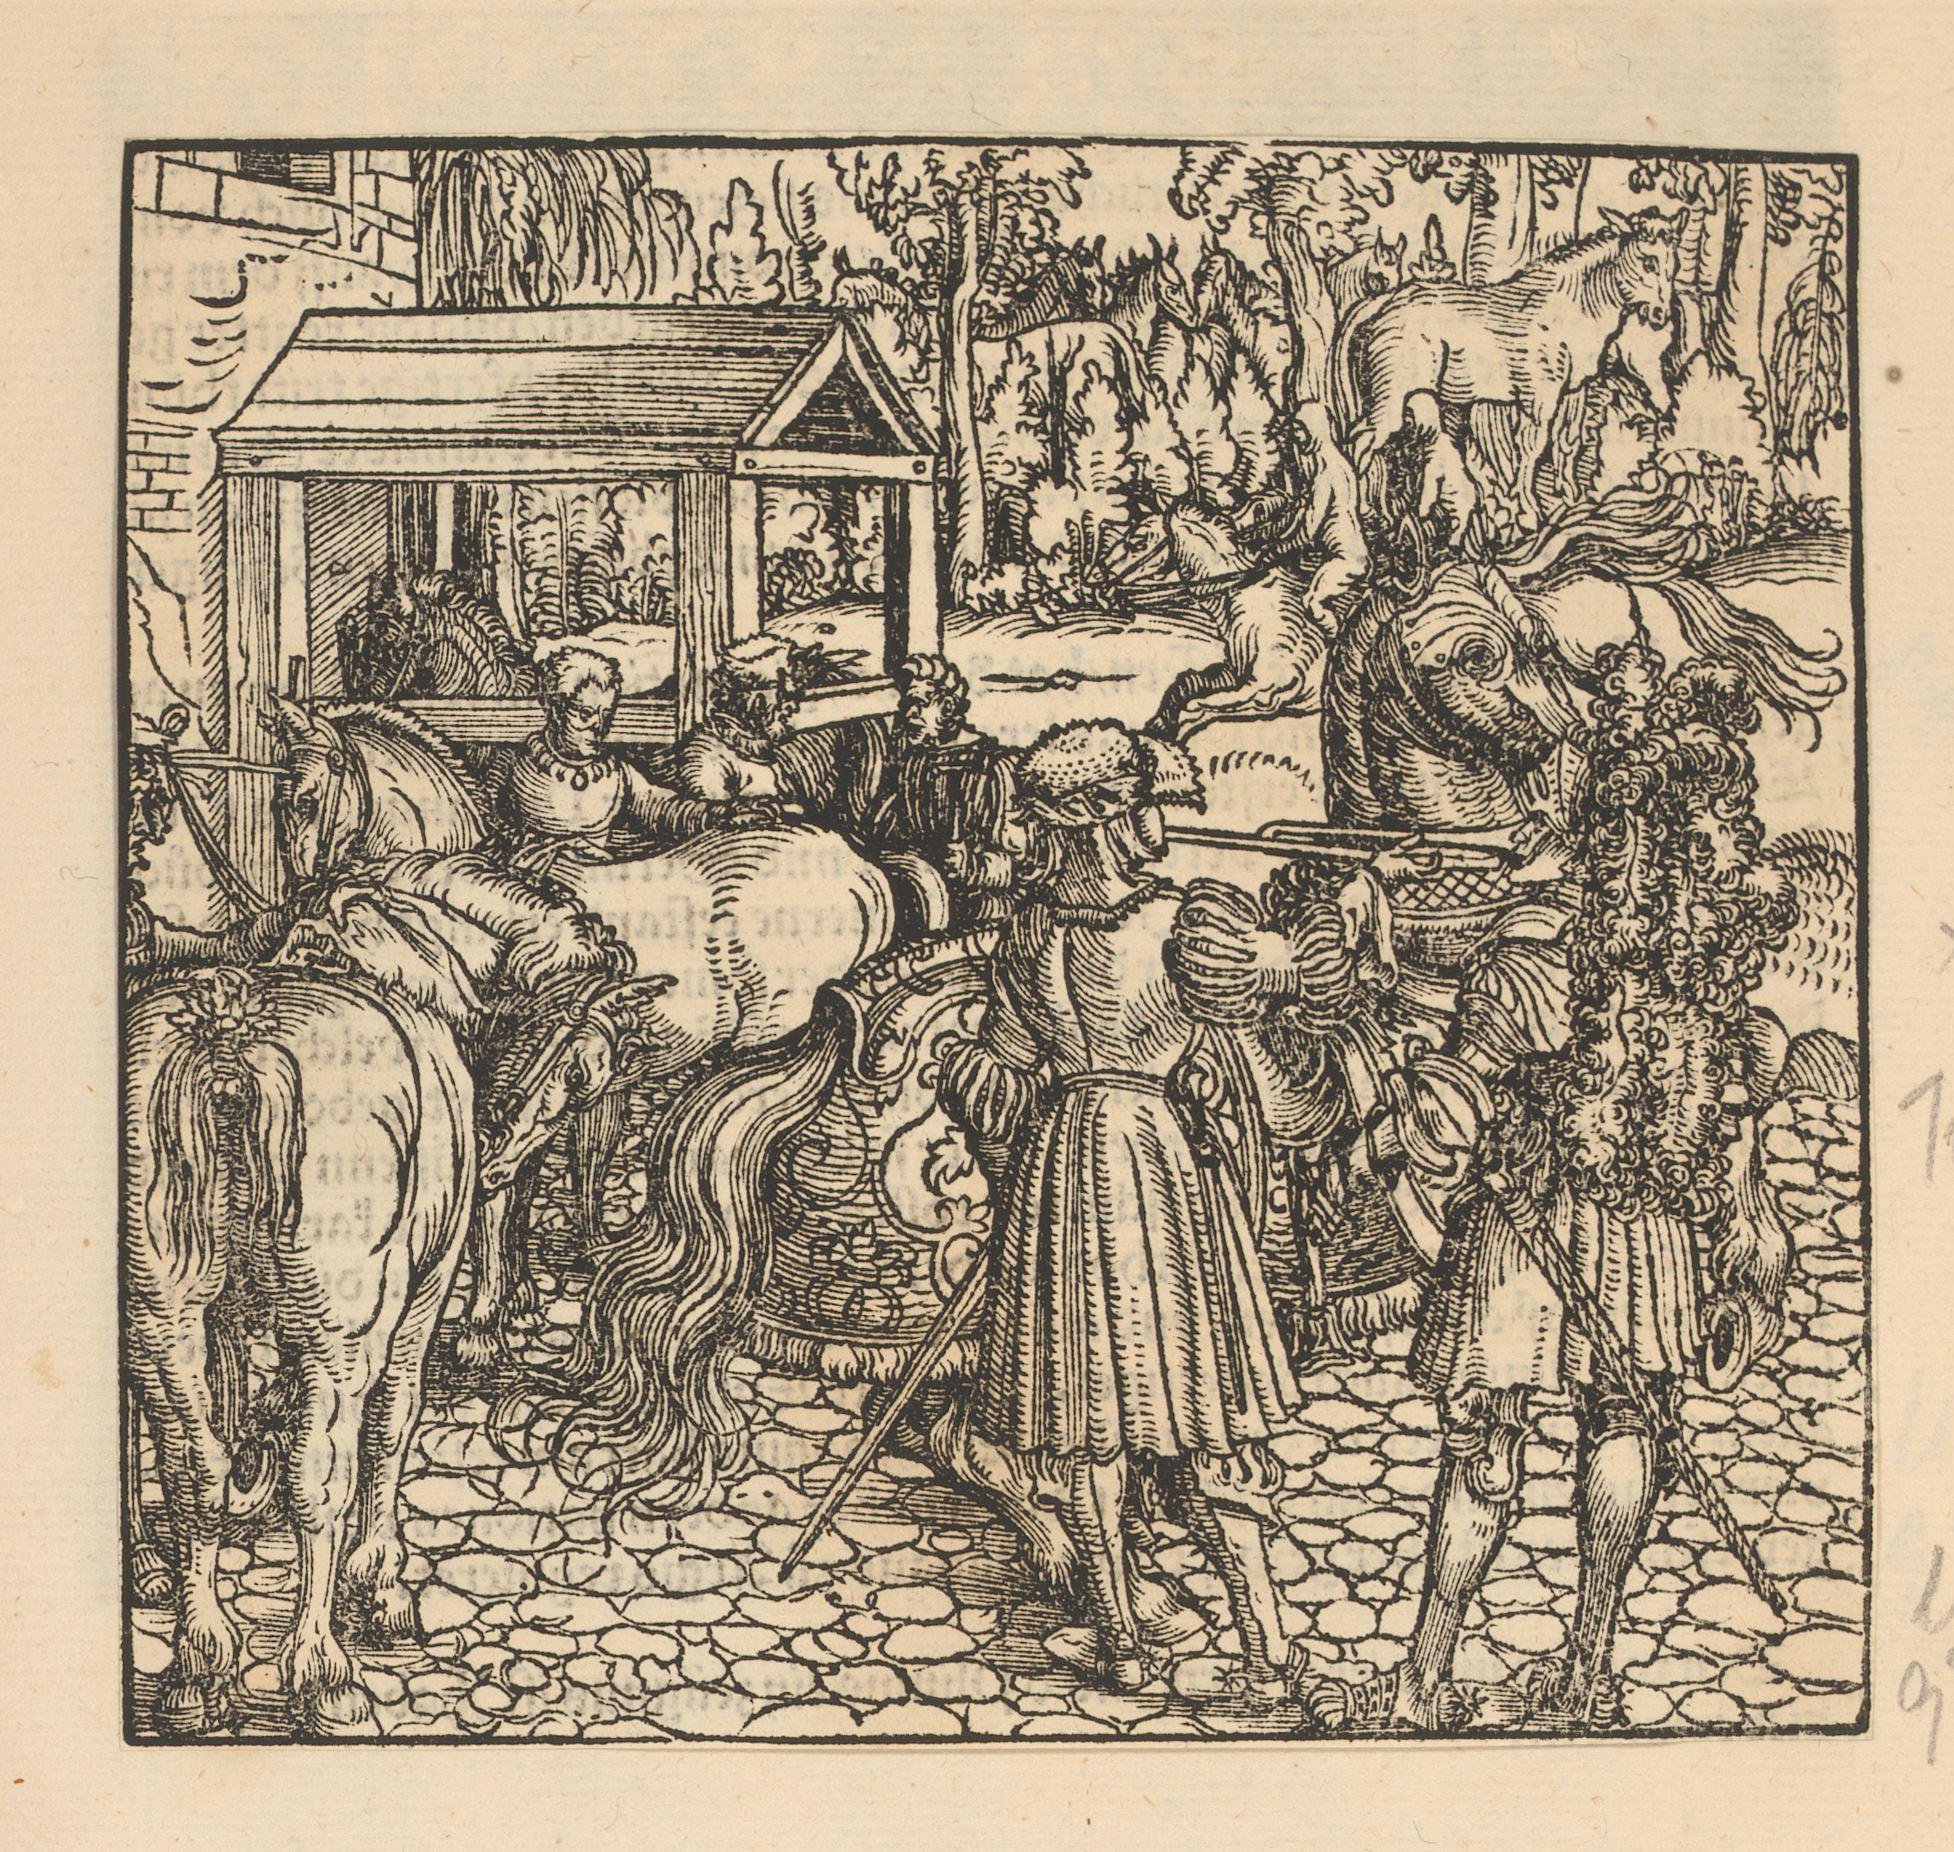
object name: book illustration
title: Ridders bij een stoeterij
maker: Anonymous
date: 1514-1532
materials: paper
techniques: letterpress printing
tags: riding a horse, ass, or mule; rider, horseman, stud farm, knight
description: Deze prent is gebruikt in: Petrarca, Francesco. Von der Artzney bayder Glück, des guten und widerwertigen: unnd weß sich ain yeder inn Gelück und Unglück halten sol (...). Augsburg: Heinrich Steiner, 1532. Deze uitgave is ook bekend onder de titel 'Trostspiegel in Glück und Unglück'.